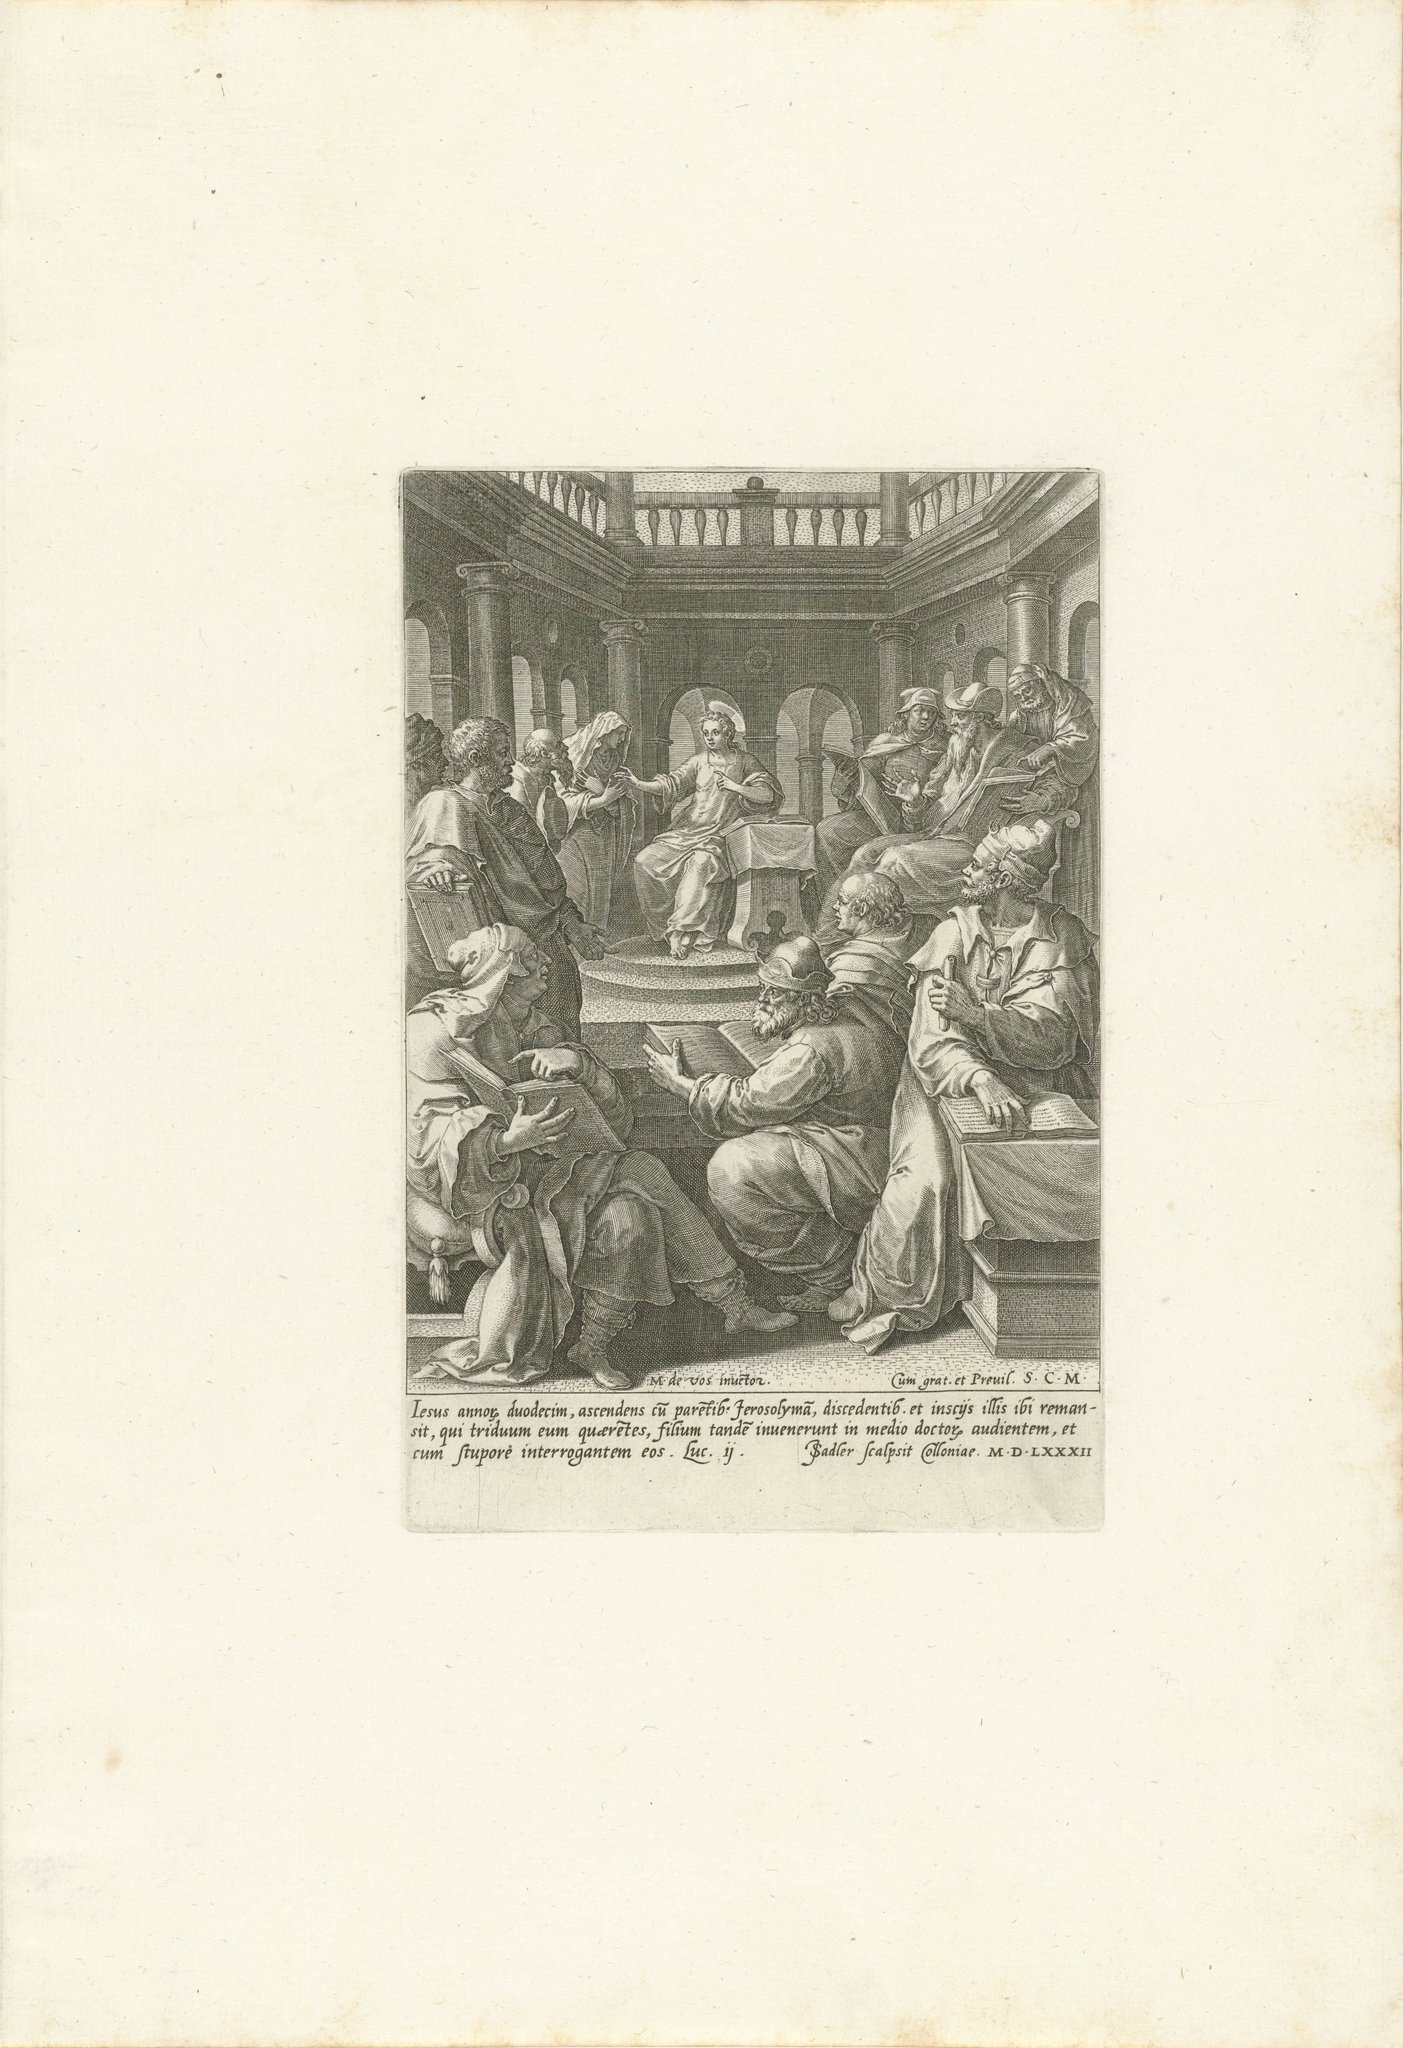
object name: print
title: Geboorte en eerste jaren van Christus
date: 1582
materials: paper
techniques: engraving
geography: cologne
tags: christ's dispute with the doctors in the temple; he counts his arguments on his fingers, christ found by his parents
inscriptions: collector's mark: Lugt 2228, collector's mark: Lugt 2760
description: De twaalfjarige Christus in debat met de Joodse schriftgeleerden. Maria en Jozef, op zoek naar hun zoon, komen de tempel binnen. De prent heeft een Latijns Bijbelcitaat als onderschrift en is de laatste prent van een twaalfdelige serie over de geboorte en de eerste jaren van Christus.